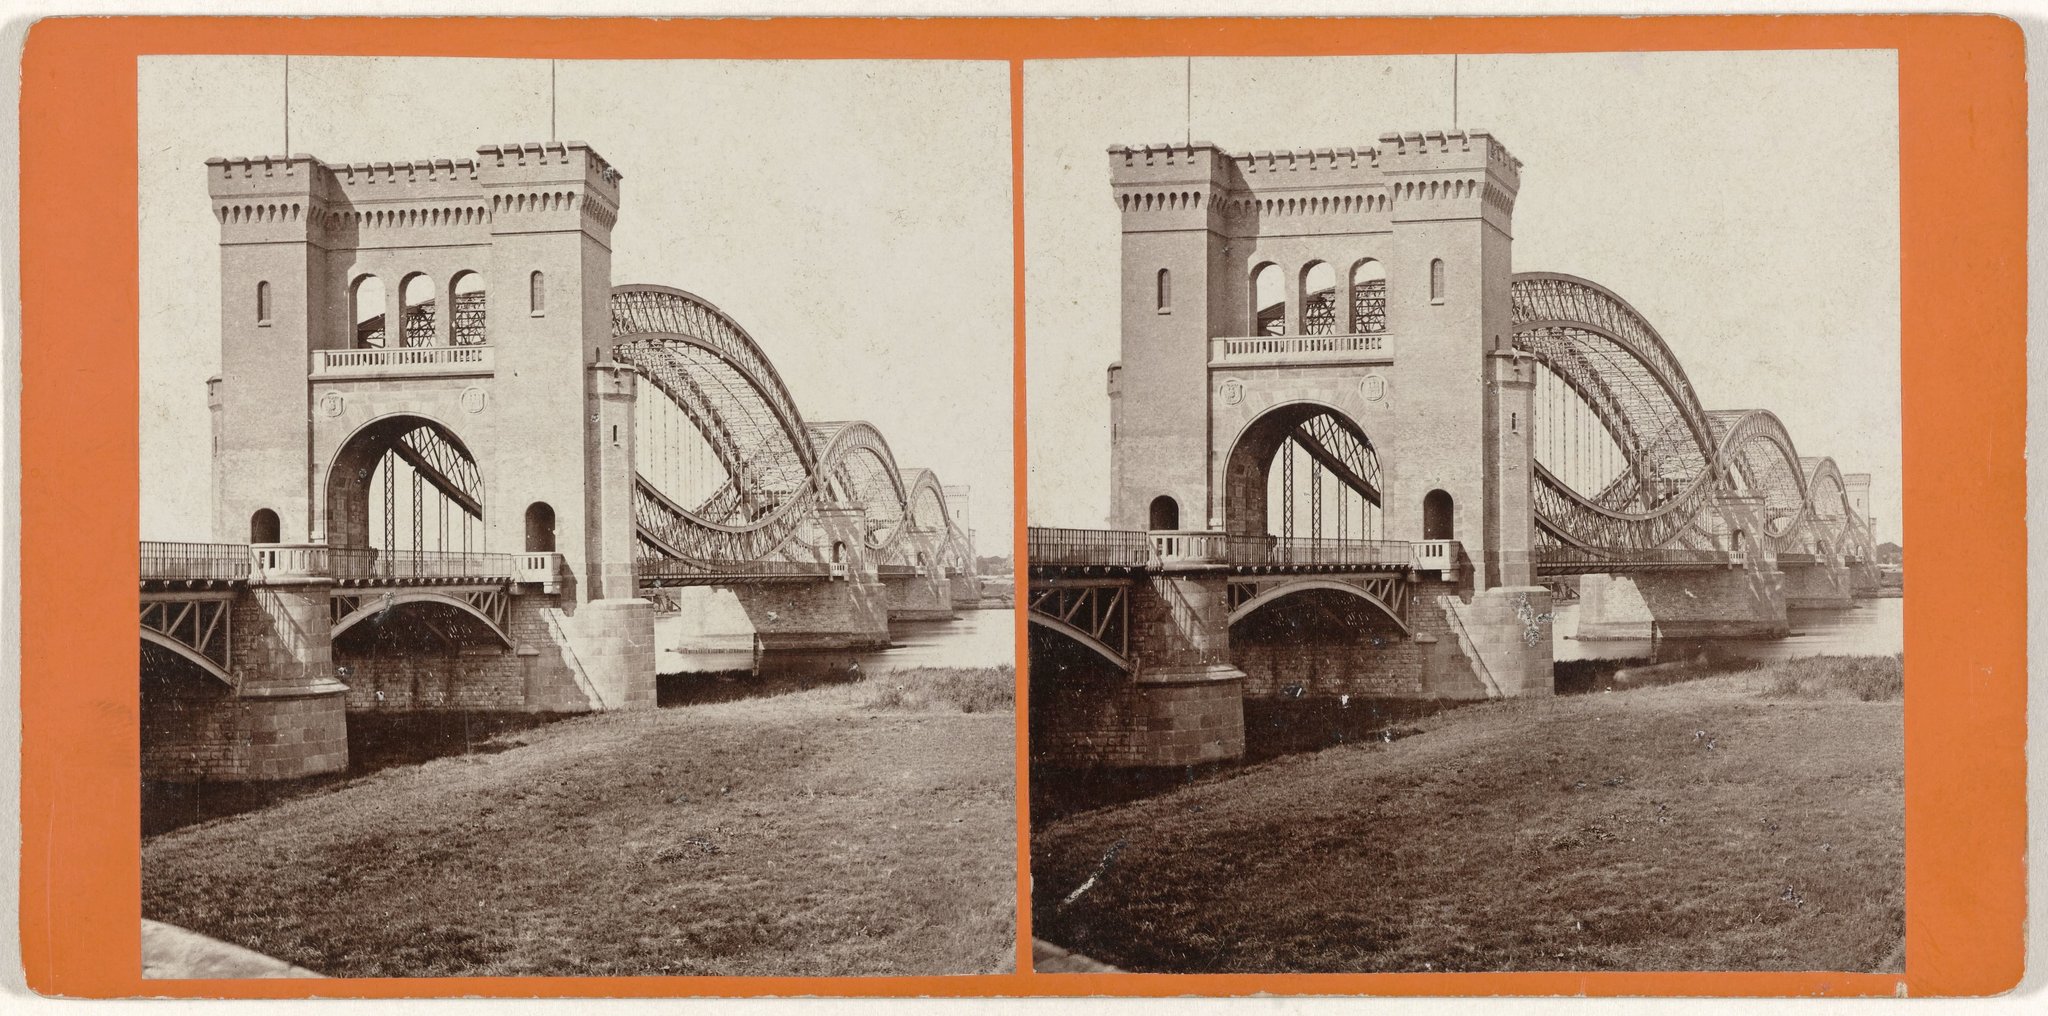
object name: stereograph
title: Hamburg, Elbbrücke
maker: Anonymous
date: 1873-1890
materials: cardboard, photographic support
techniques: gelatin silver print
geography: hamburg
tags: bridge in city across river, canal, etc.